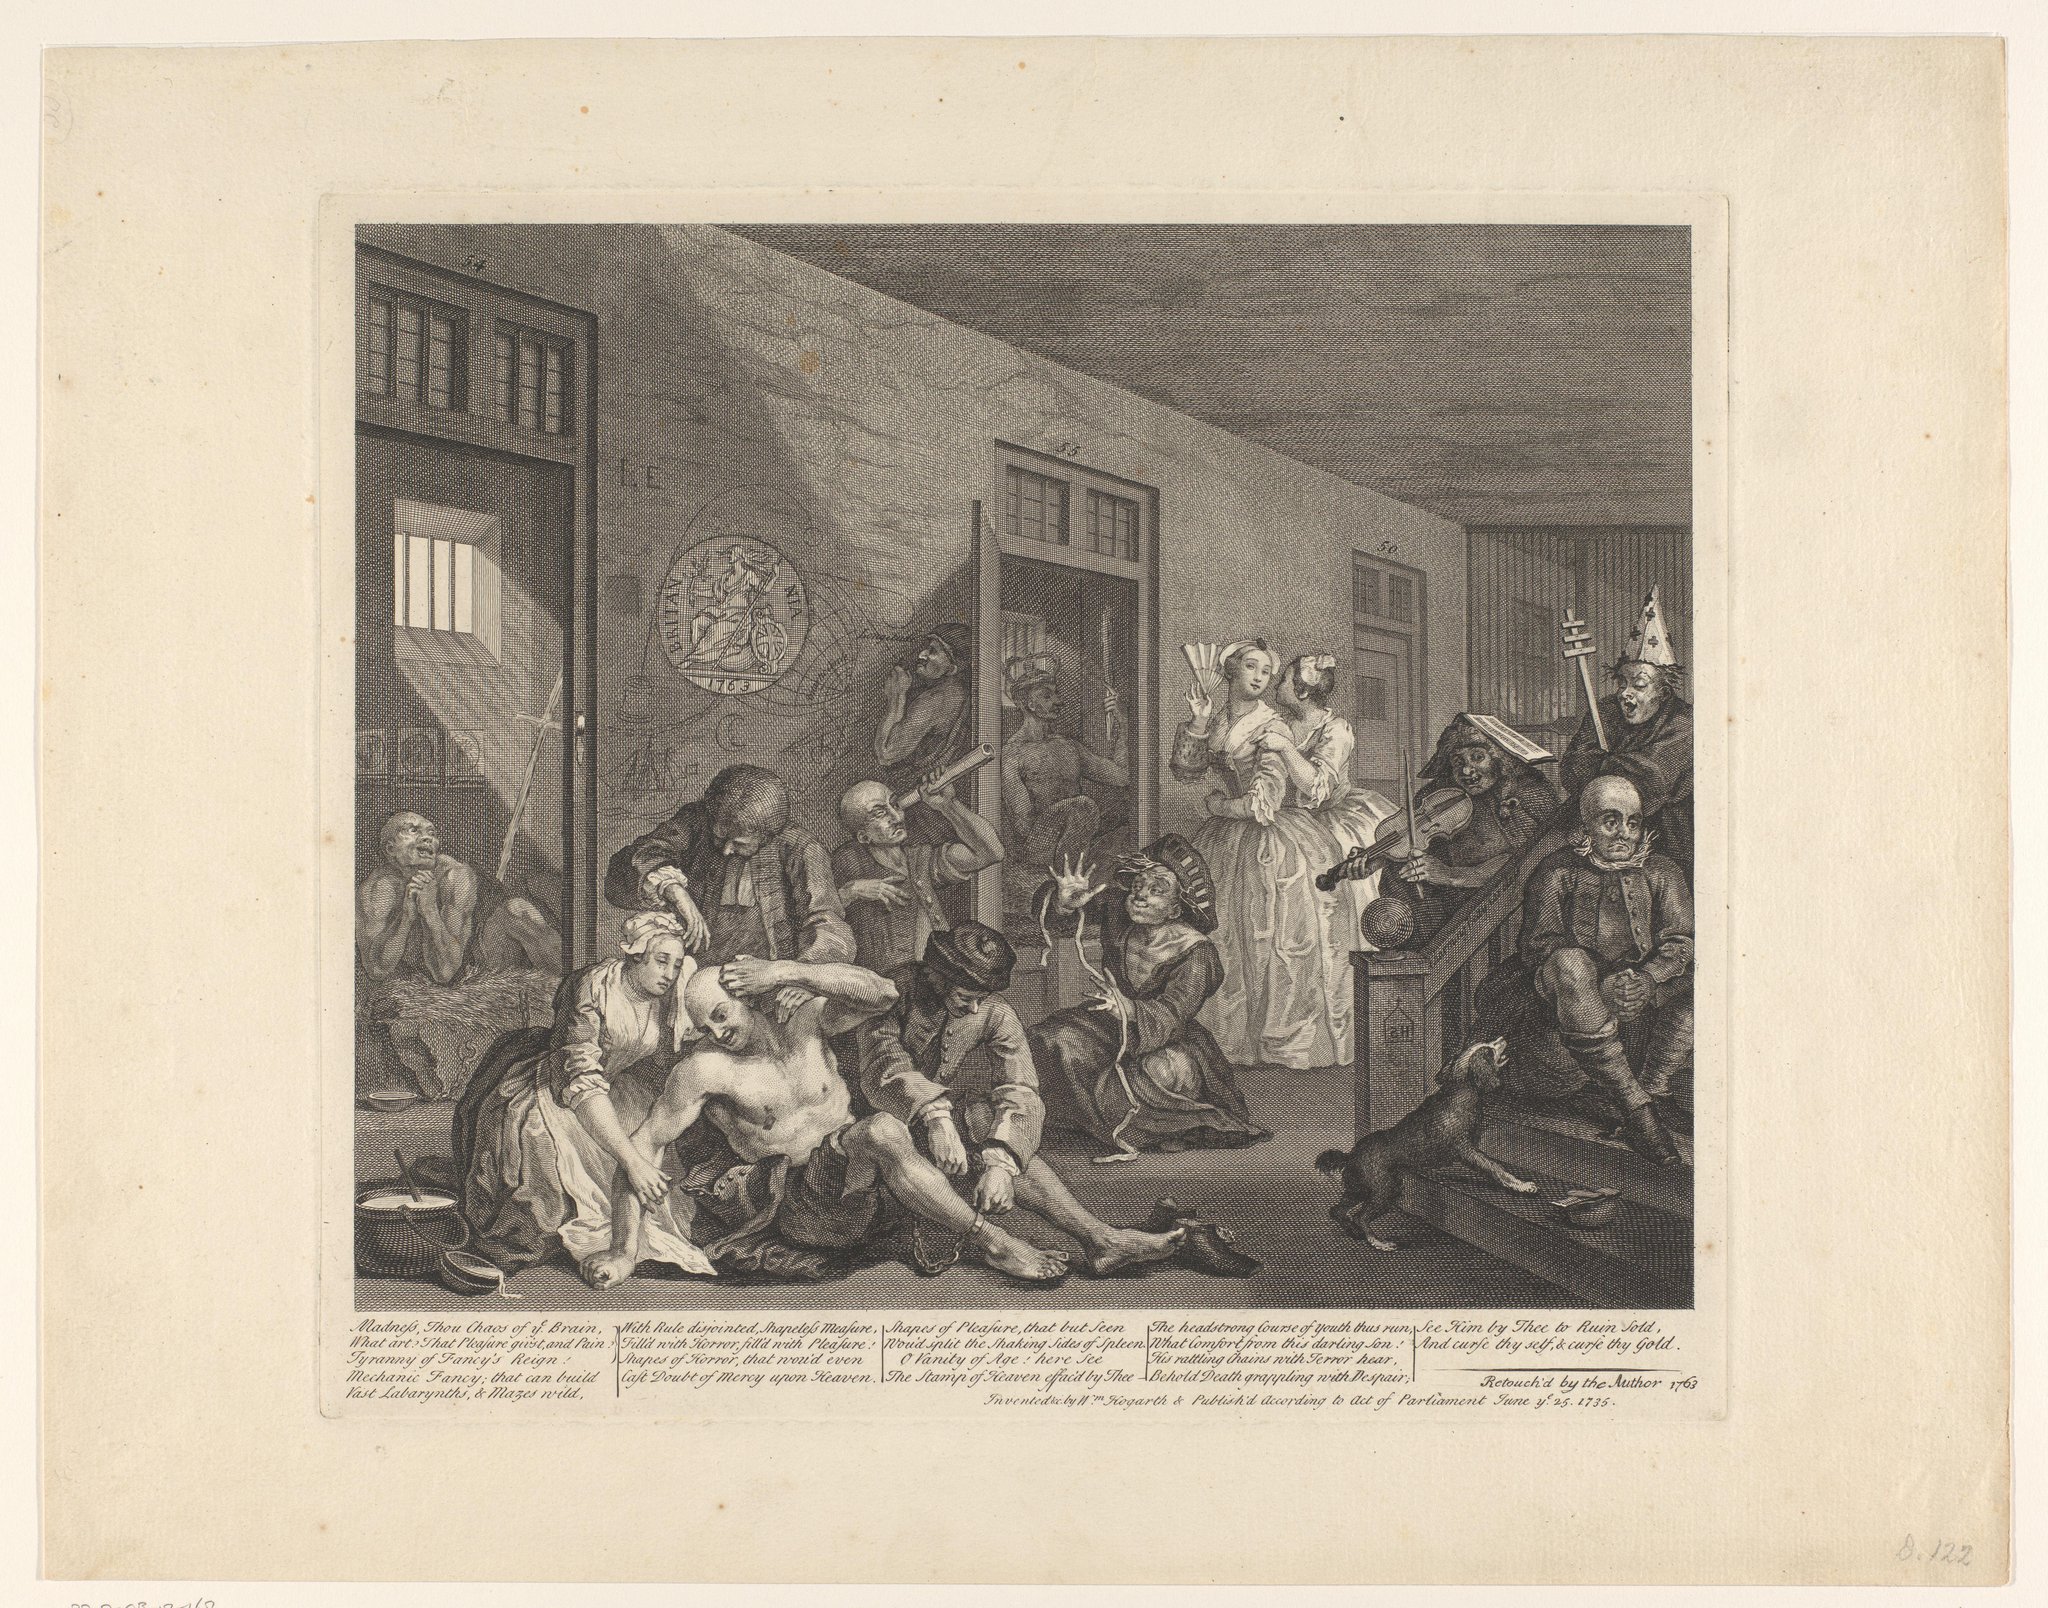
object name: print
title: The Rake's Progress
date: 1735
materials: paper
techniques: engraving, etching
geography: london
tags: lunatic asylum, mental home, political caricatures and satires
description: Tekst in het Engels in de ondermarge. Tom, klaarblijkelijk gek geworden, wordt ondersteund door Sarah Young. Om hen heen verschillende patiënten uit de psychiatrische inrichting 'Bedlam'. De hooggeplaatste vrouw op de achtergrond is waarschijnlijk op bezoek in het asiel ter vermaak. Op de muur een cirkel met daarin de personificatie van Engeland, Britannia.